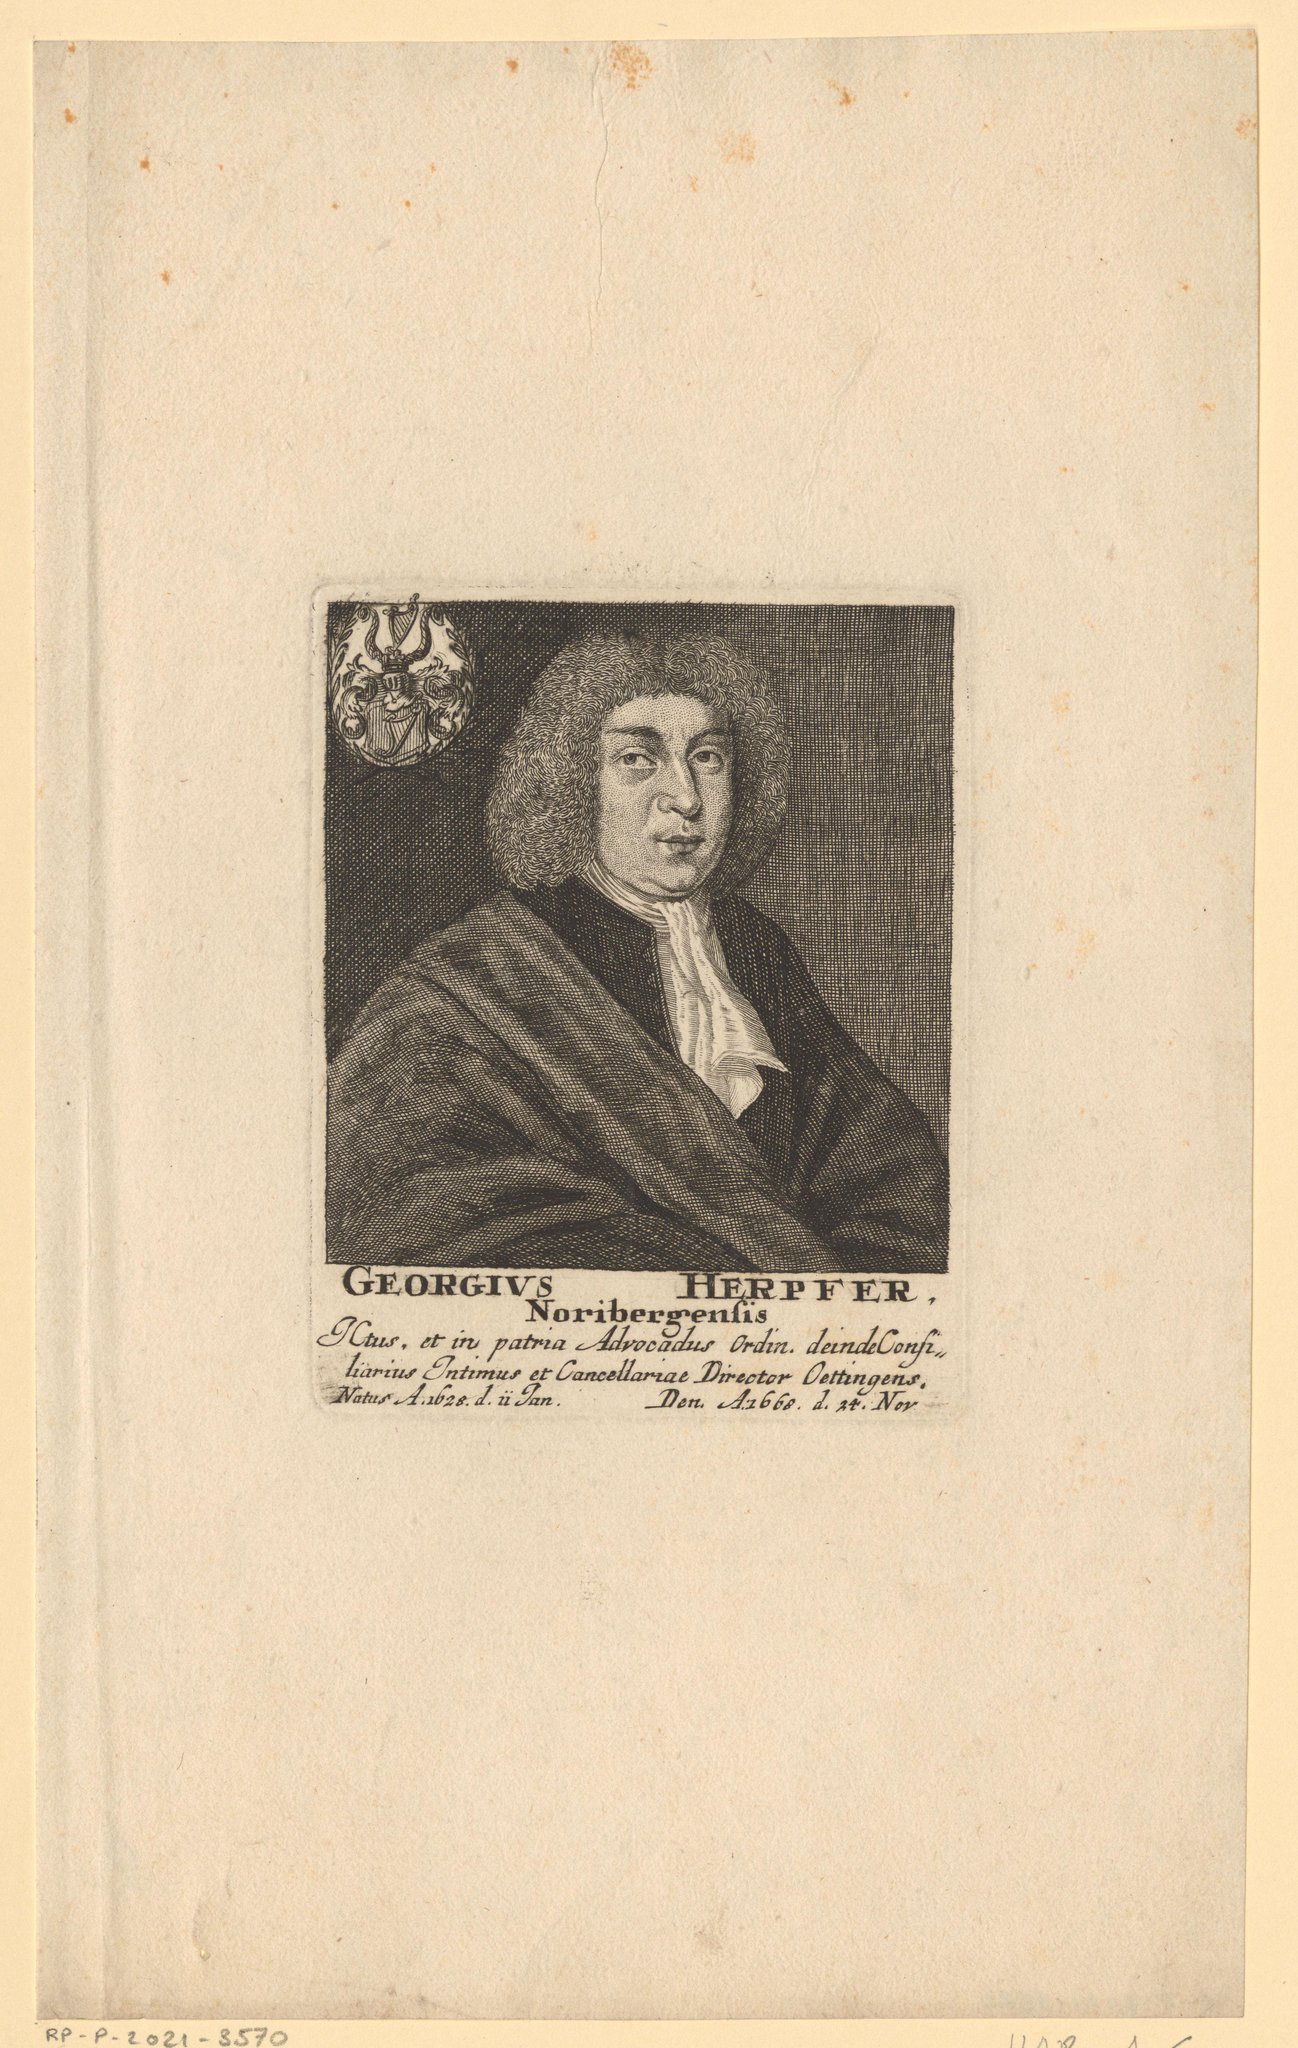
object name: print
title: Portret van Georg Herpfer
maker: Anonymous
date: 1700-1749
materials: paper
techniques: engraving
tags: historical persons, lawyer, attorney at law, armorial bearing, heraldry